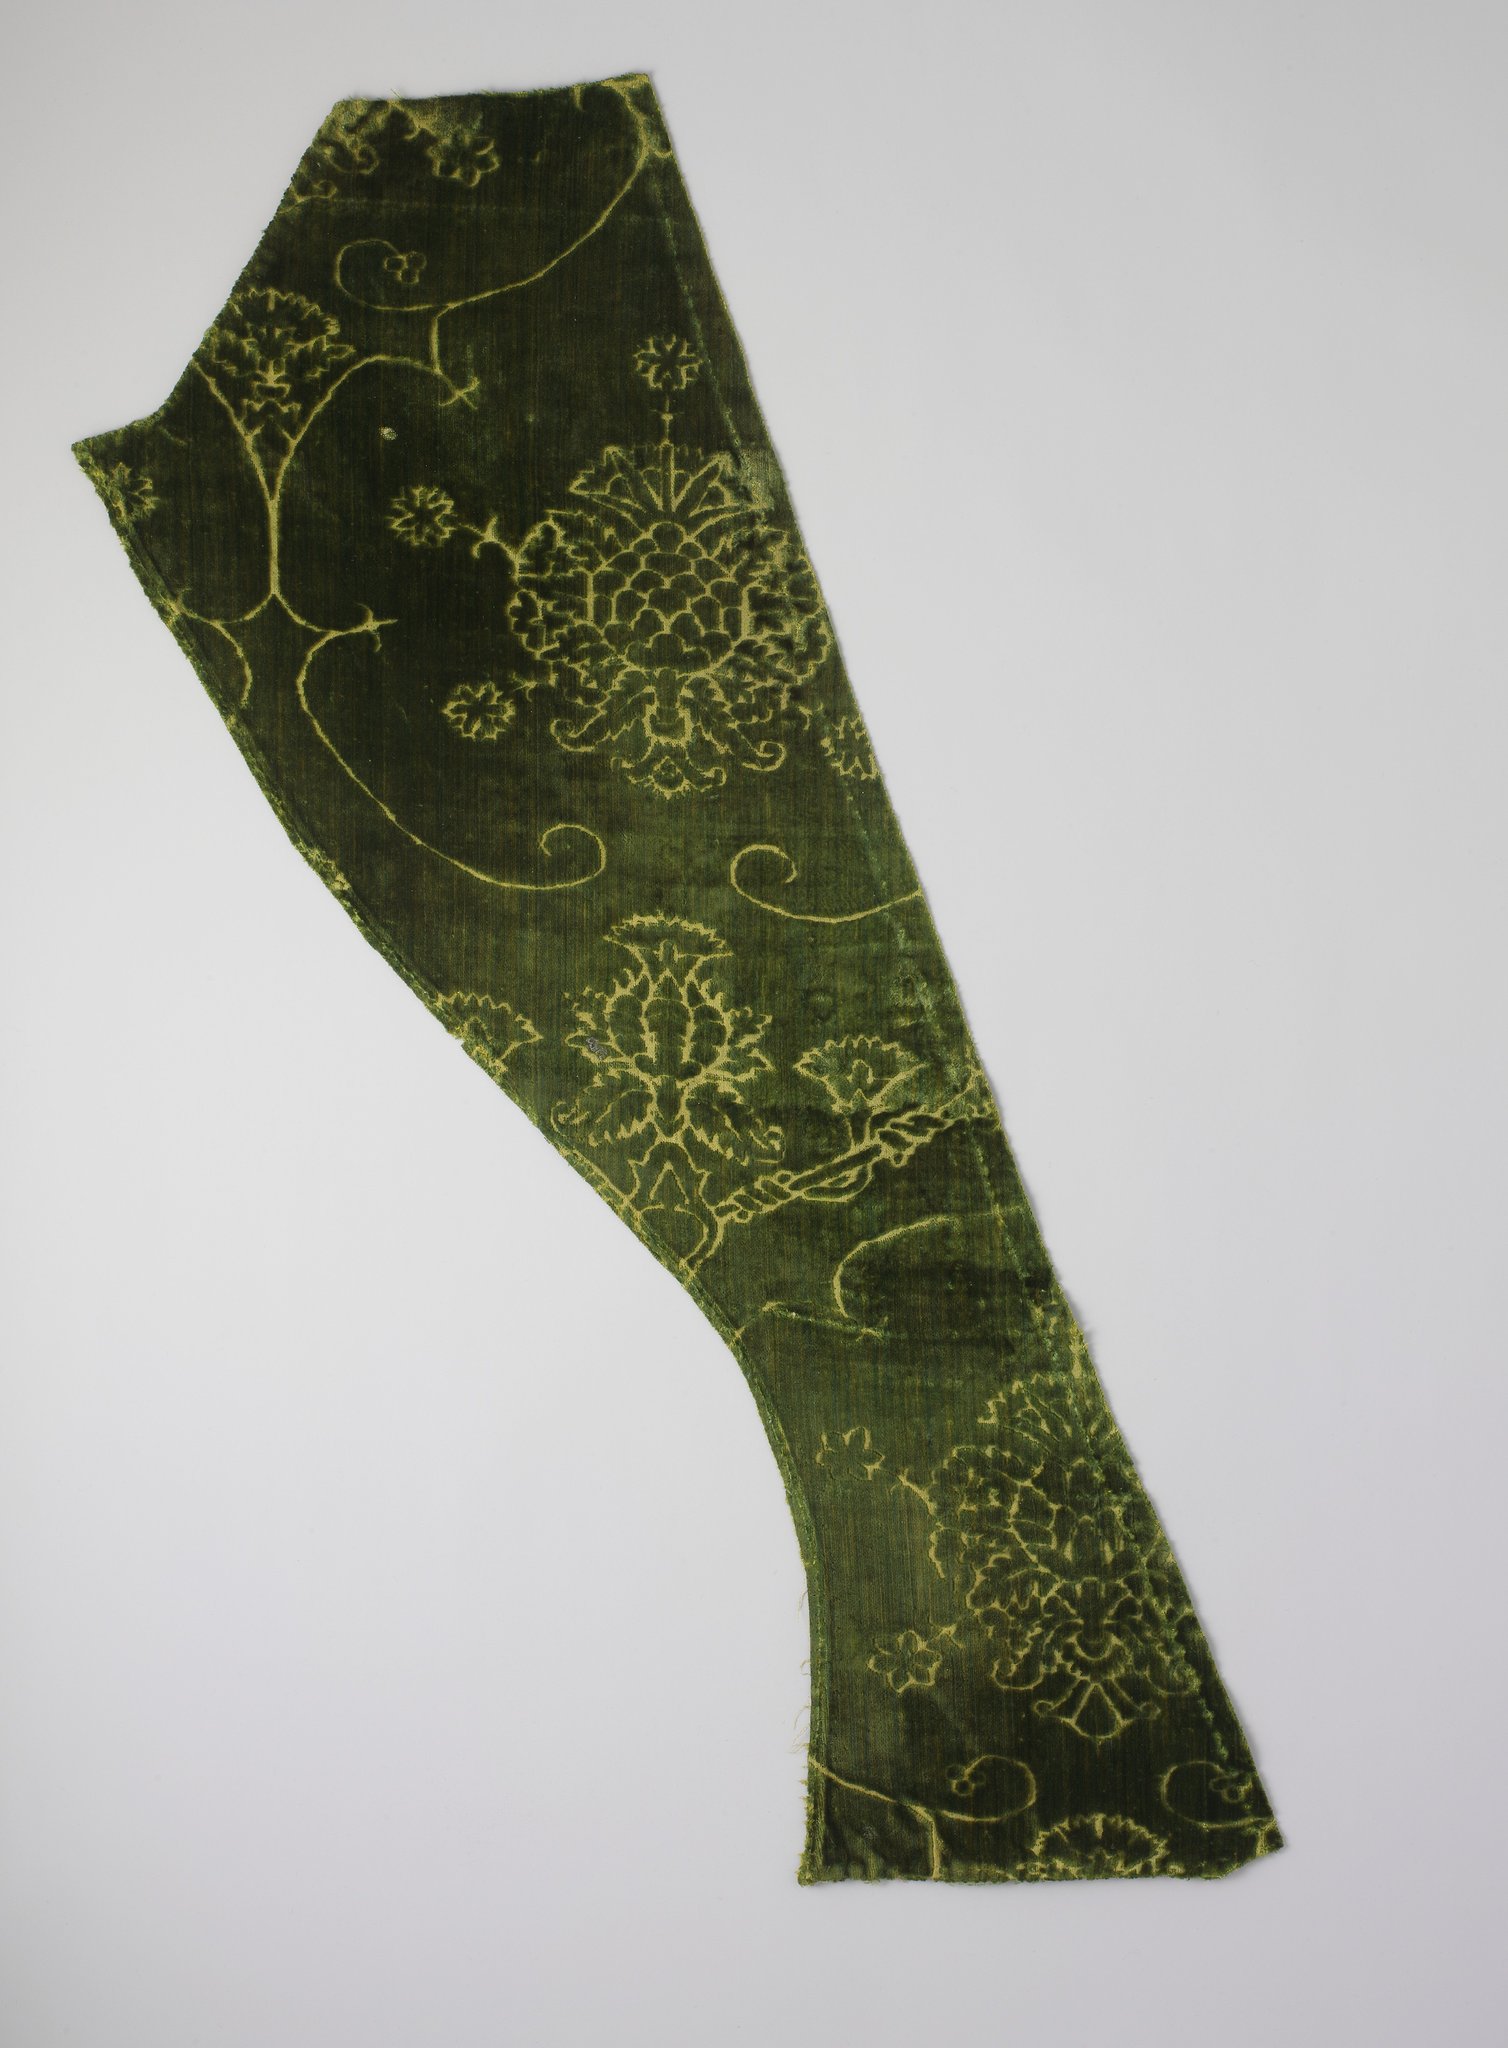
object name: piece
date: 1451-1500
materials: silk